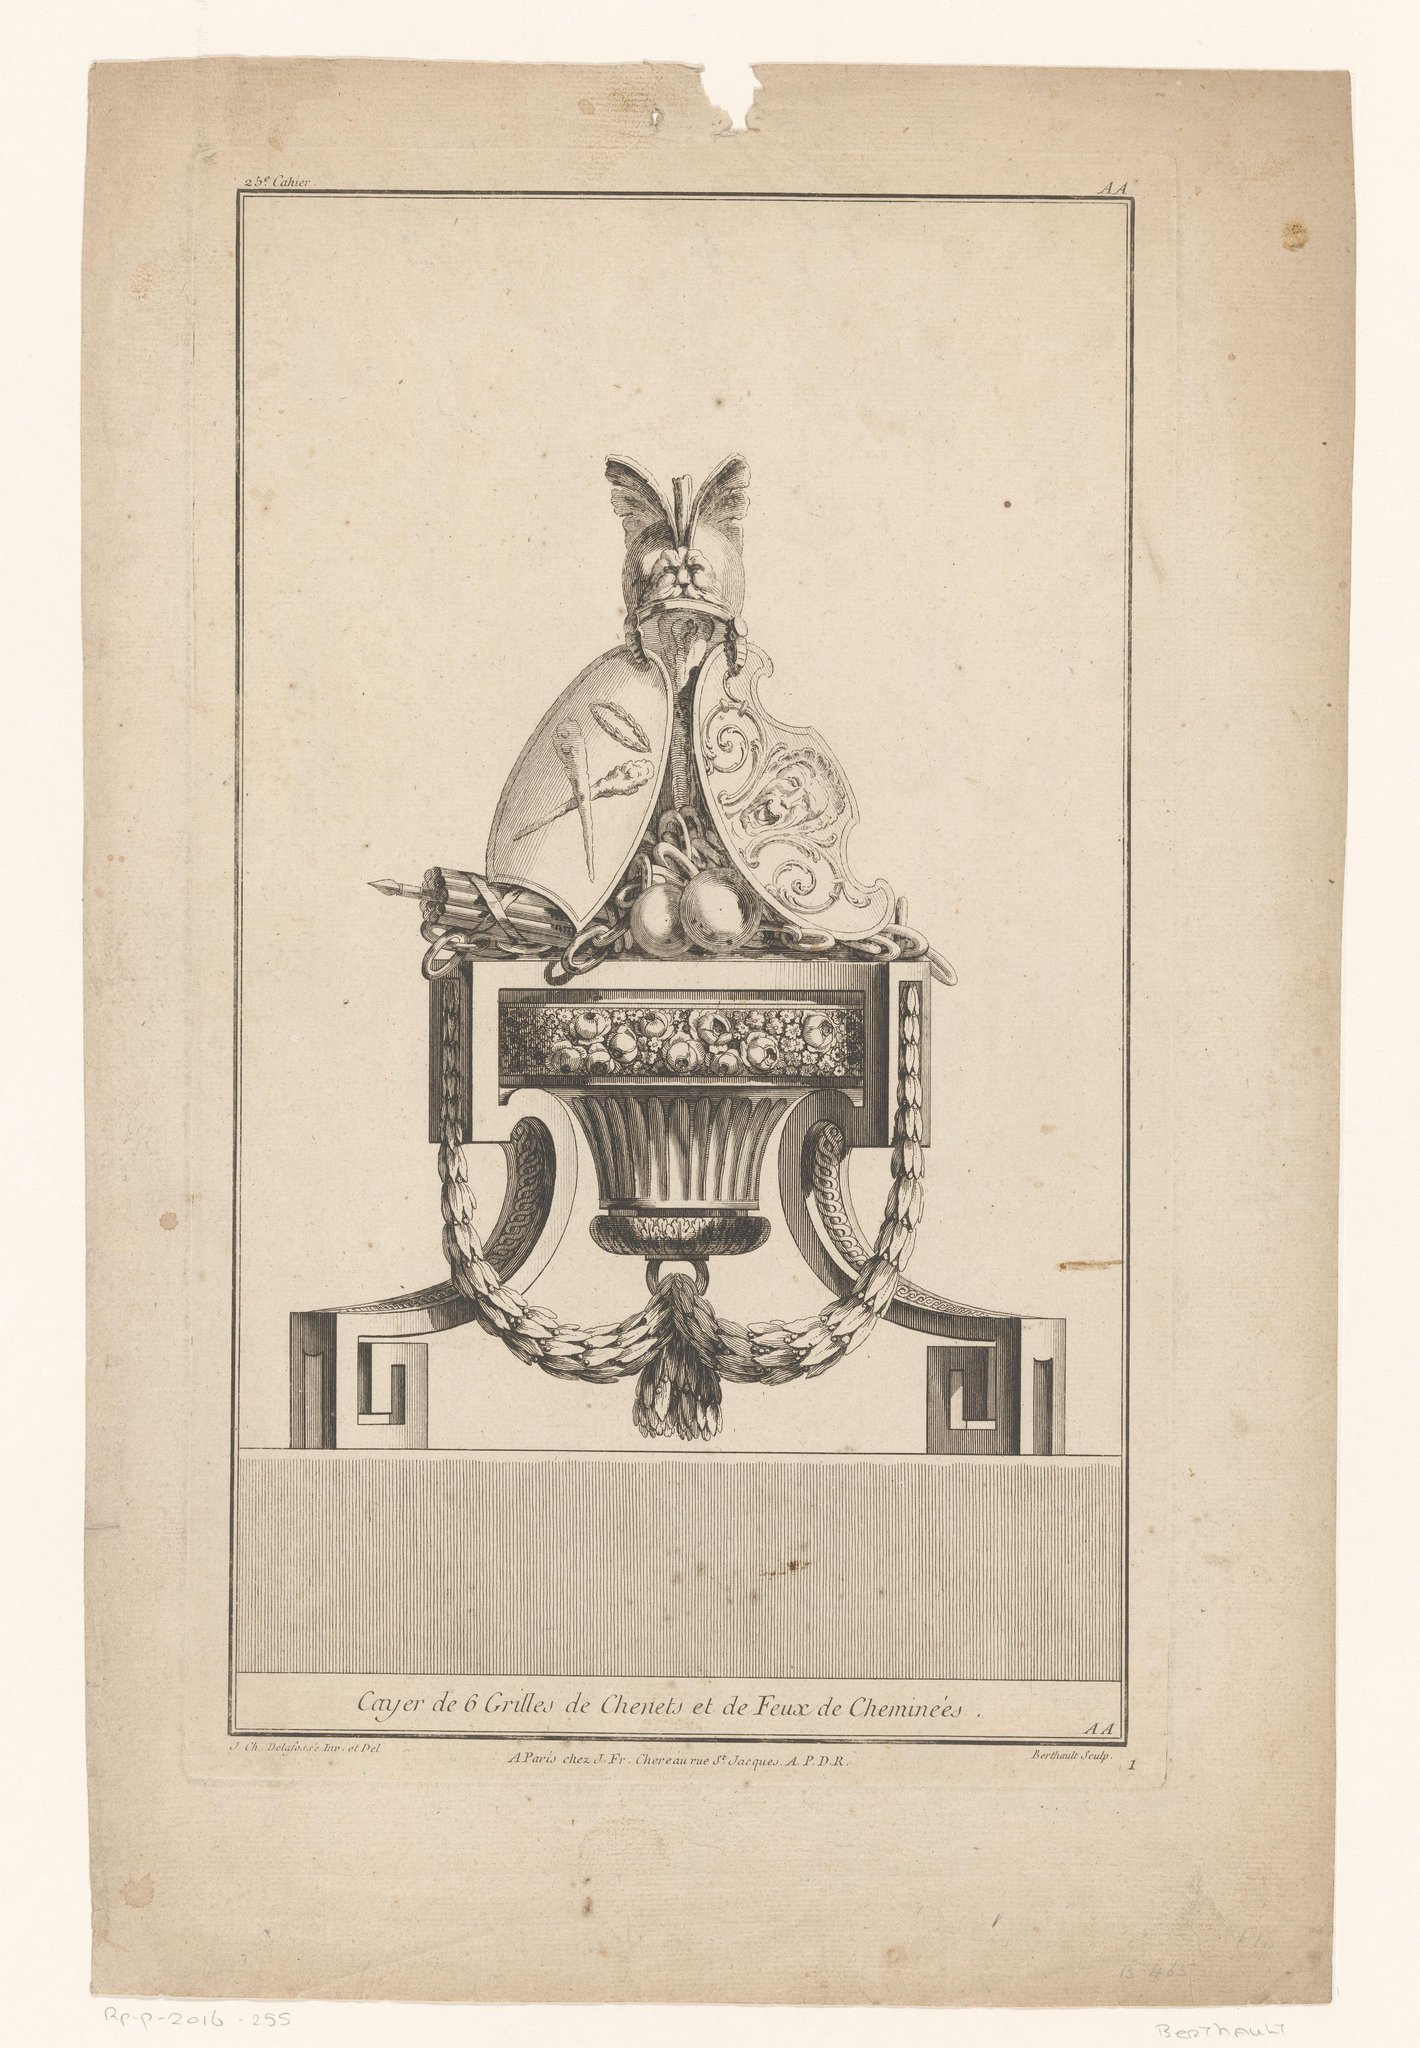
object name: ornament print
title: 25e Cahier AA Cayer de 6 Grilles de Chenets et de Feux de Cheminées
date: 1771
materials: paper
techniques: engraving, etching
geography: paris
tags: helmet, protective weapons: shield, andiron, fire-dog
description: Een geornamenteerde vuurbok met een helm, schilden, wapens en guirlandes.